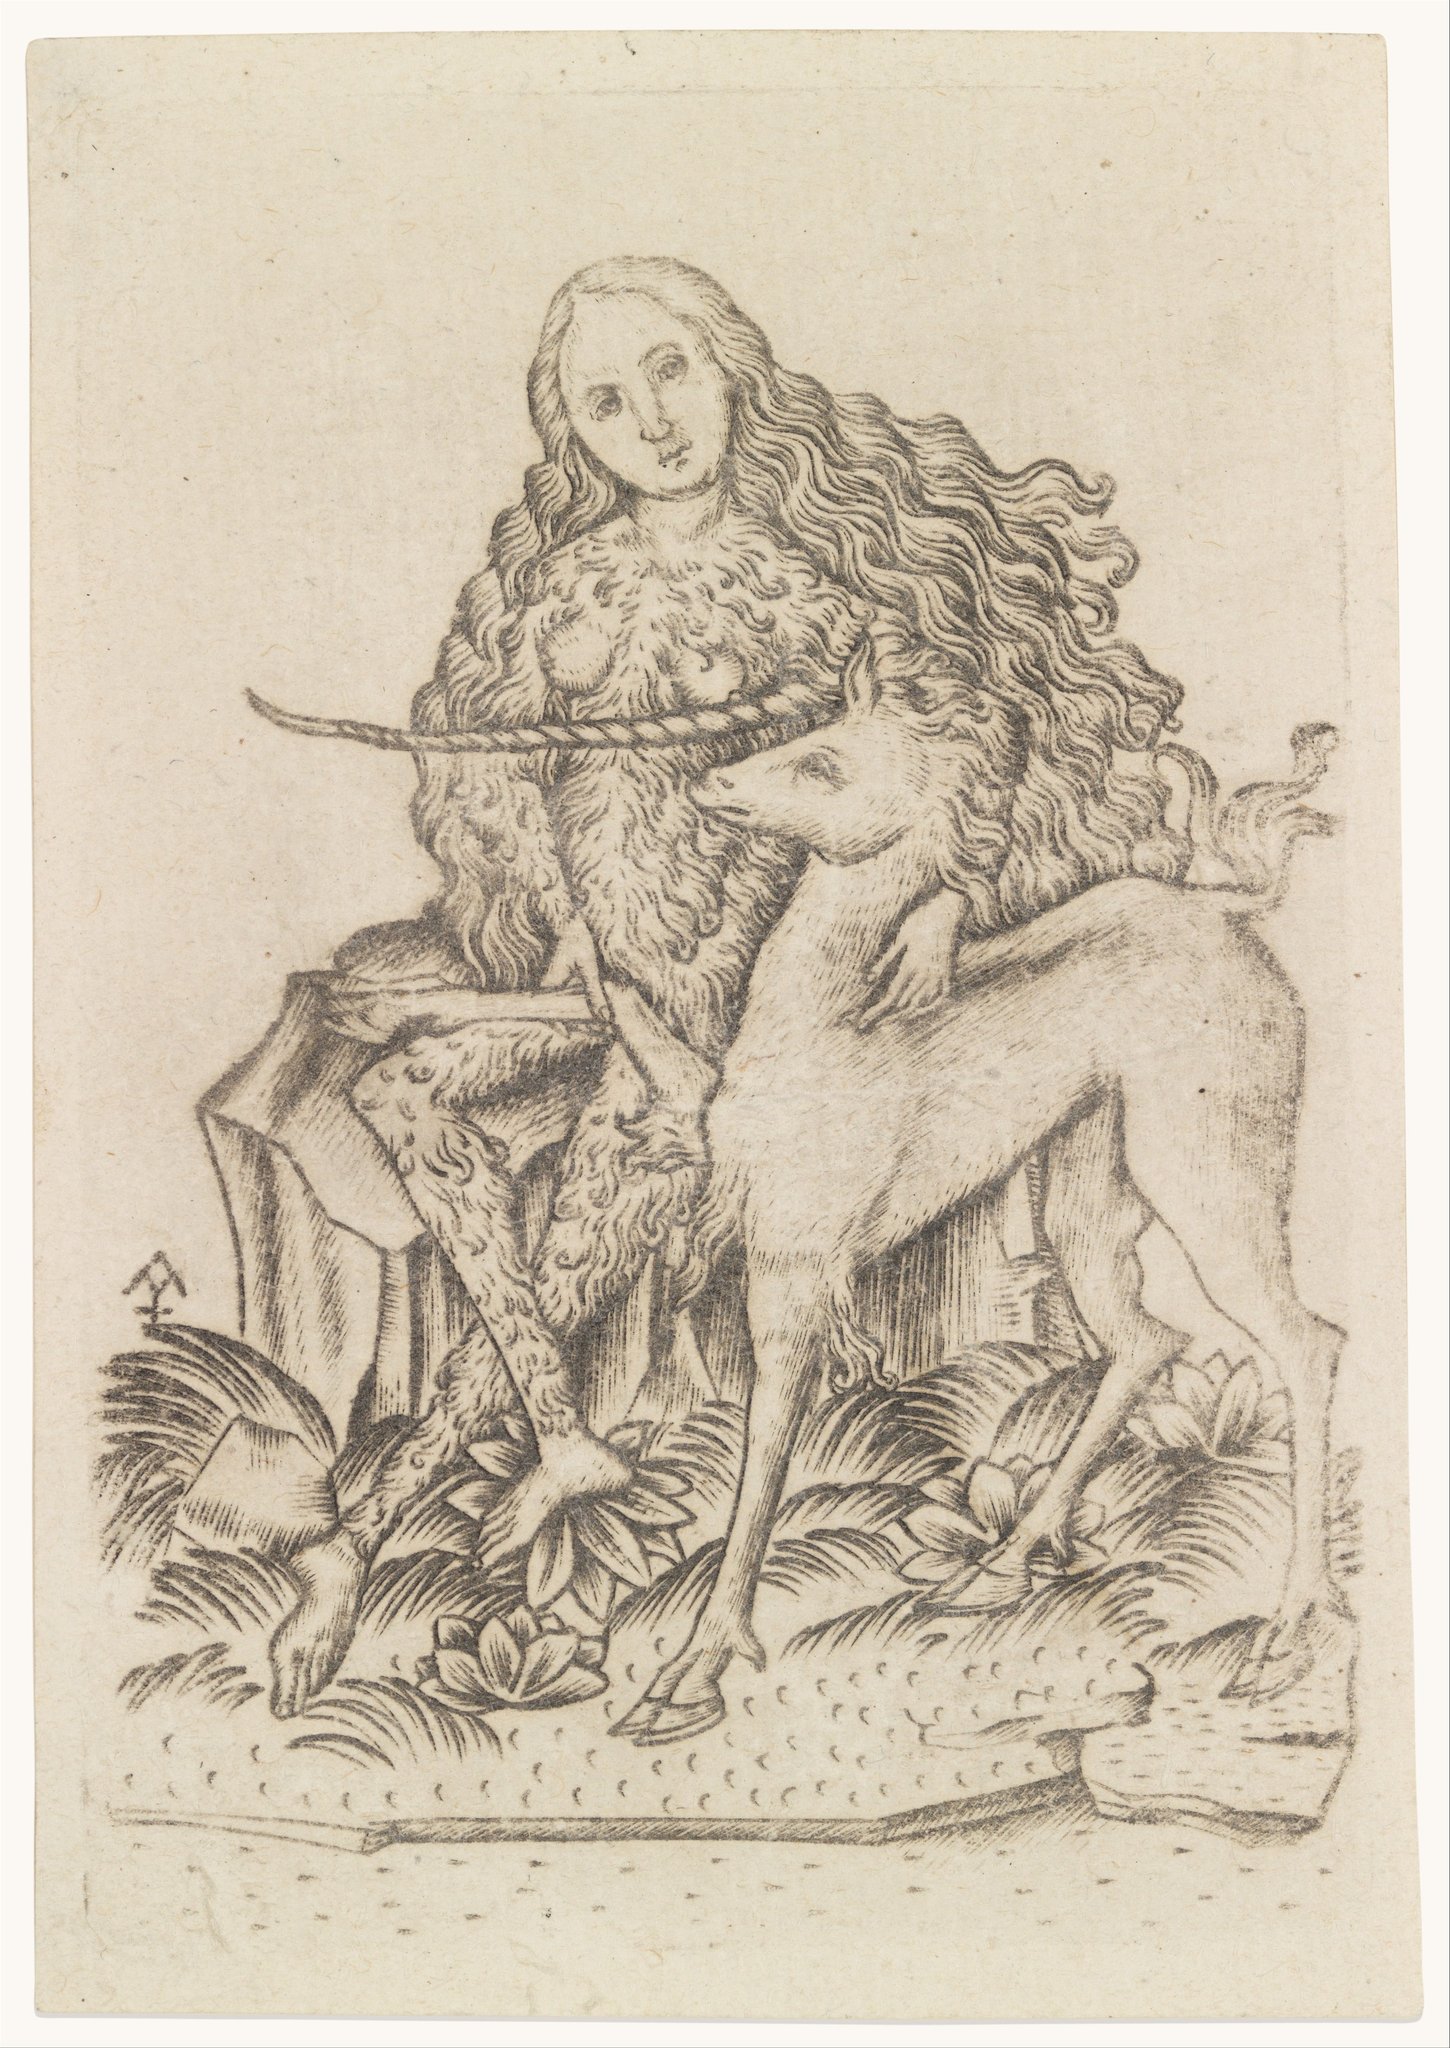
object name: print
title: Playing Card, with Wild Woman and Unicorn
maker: master es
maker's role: artist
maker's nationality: german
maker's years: 1445-1467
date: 1401-1500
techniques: engraving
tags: women,playing cards,unicorns